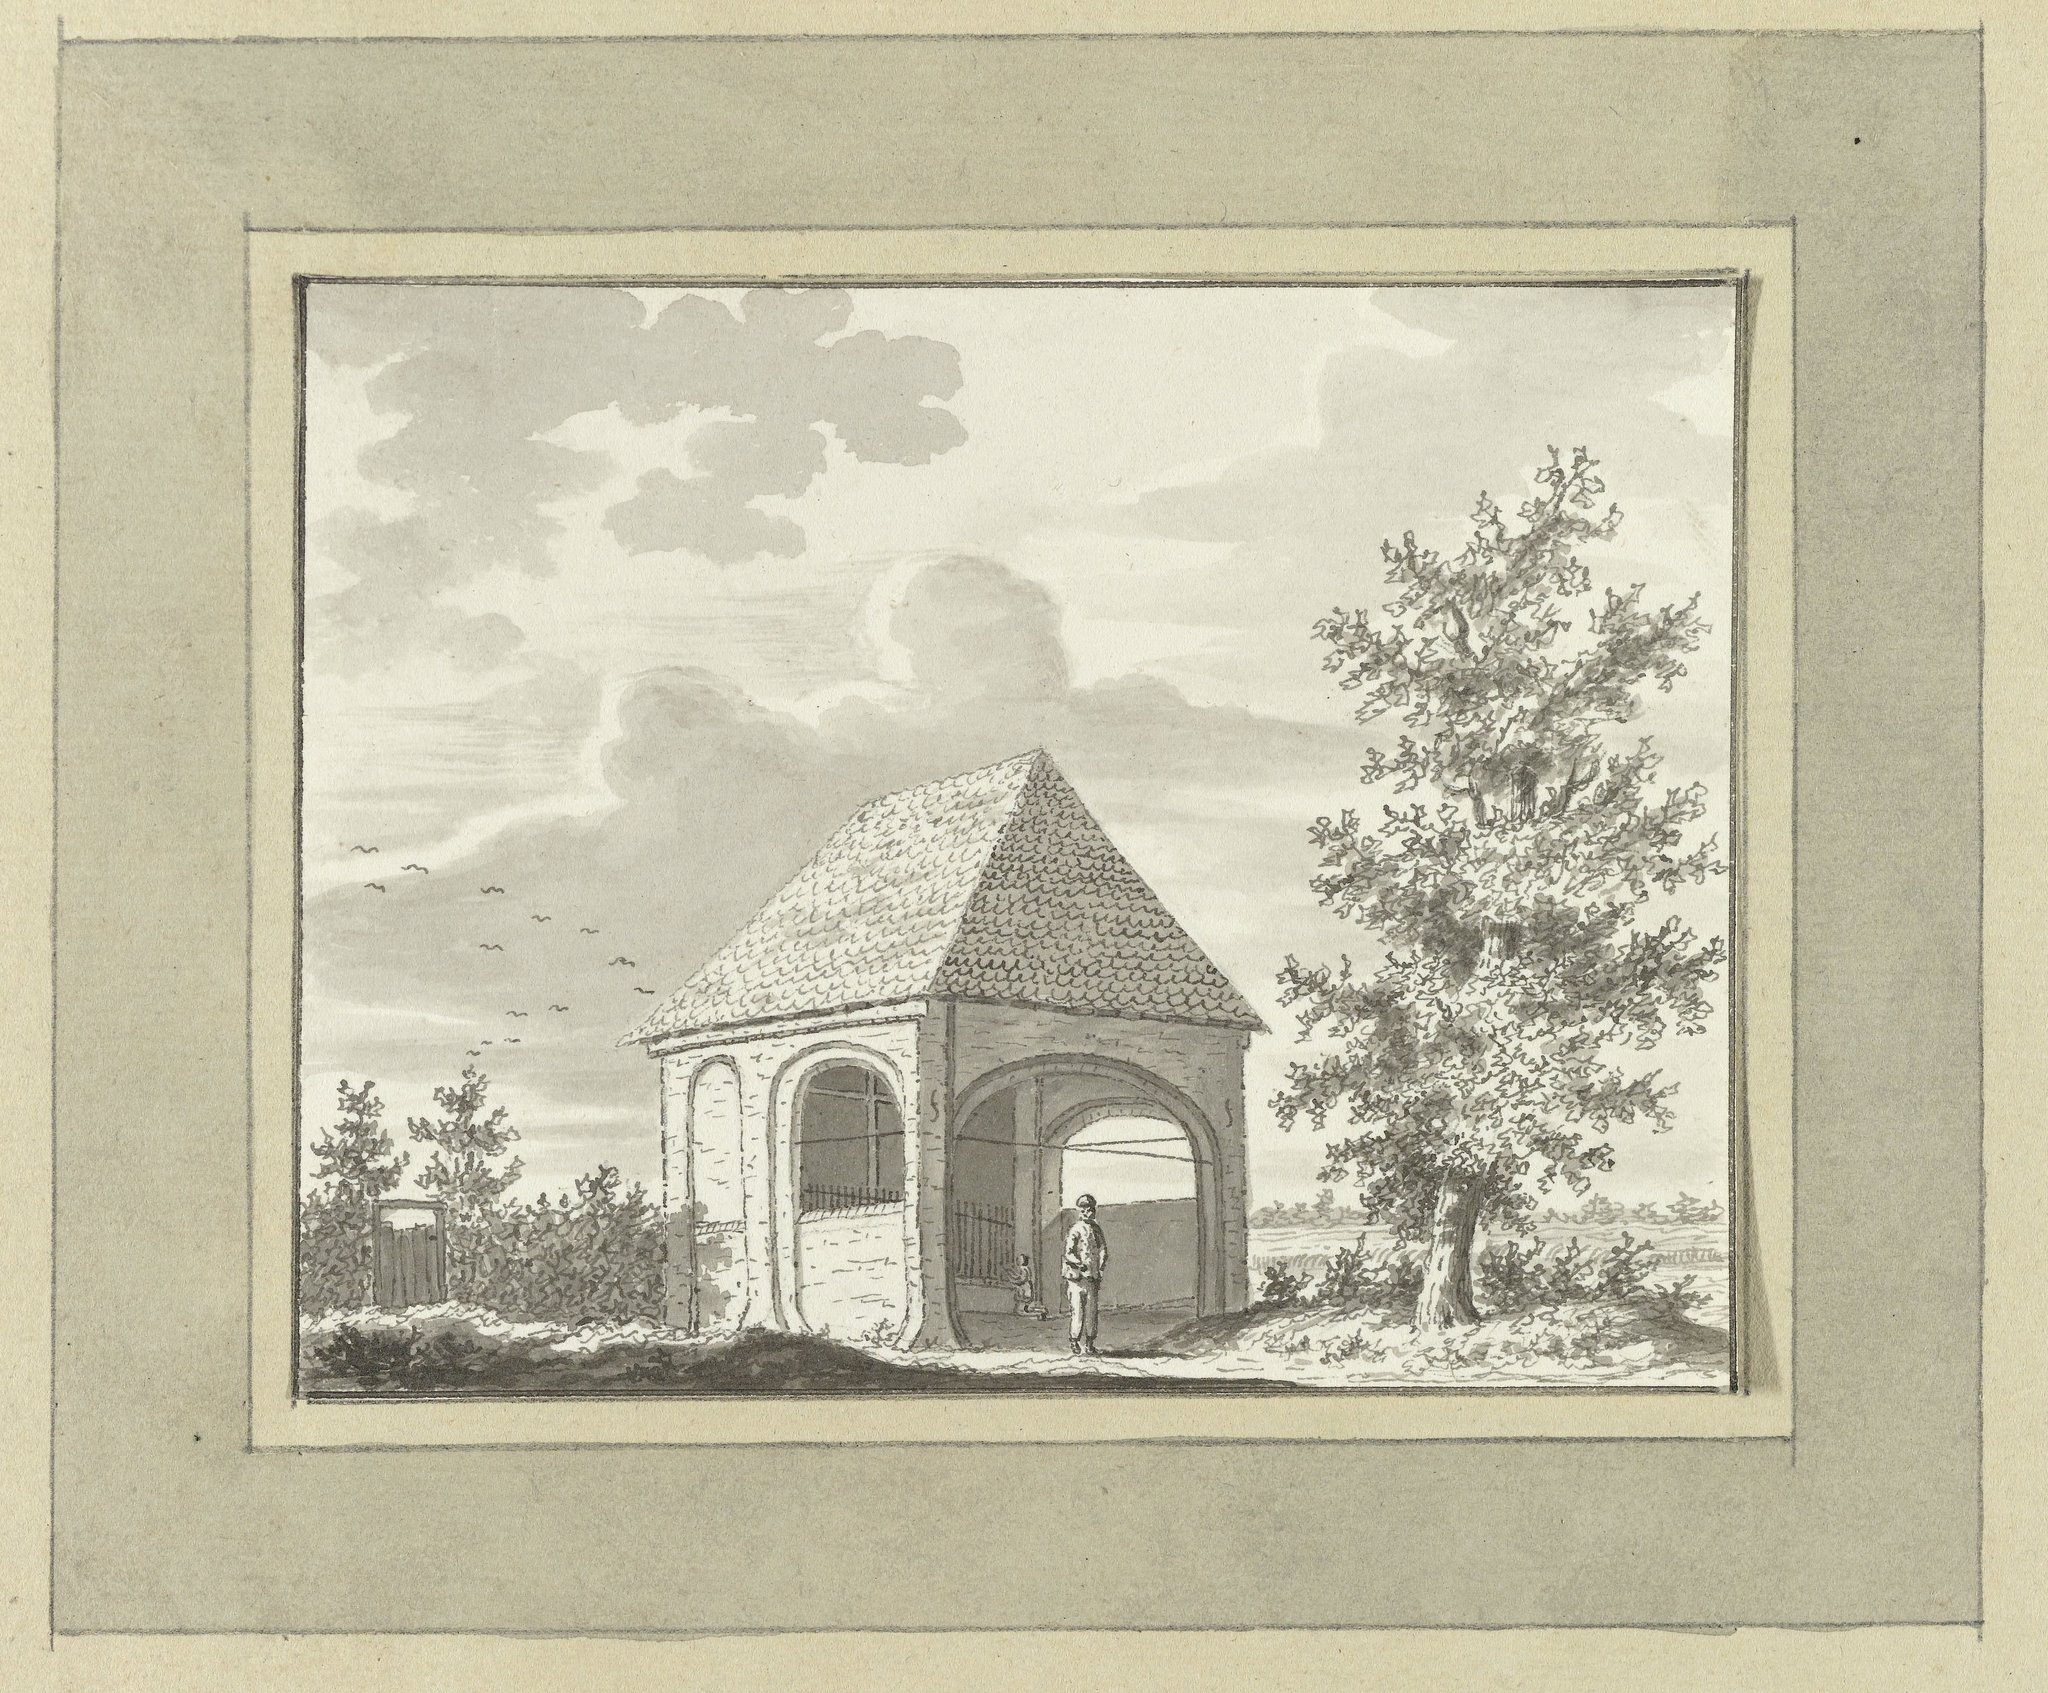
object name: drawing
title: Kapel bij Ziegtelen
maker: ernst willem jan bagelaar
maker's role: draughtsman, print maker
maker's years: 1775-1837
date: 1800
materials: paper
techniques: brush, pen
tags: landscapes in the temperate zone, church (exterior) - qq - small church, chapel, germany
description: Tekening uit album met 13 tekeningen gemaakt in Duitsland door kapitein Bagelaar, gedurende de veldtocht van 1800.